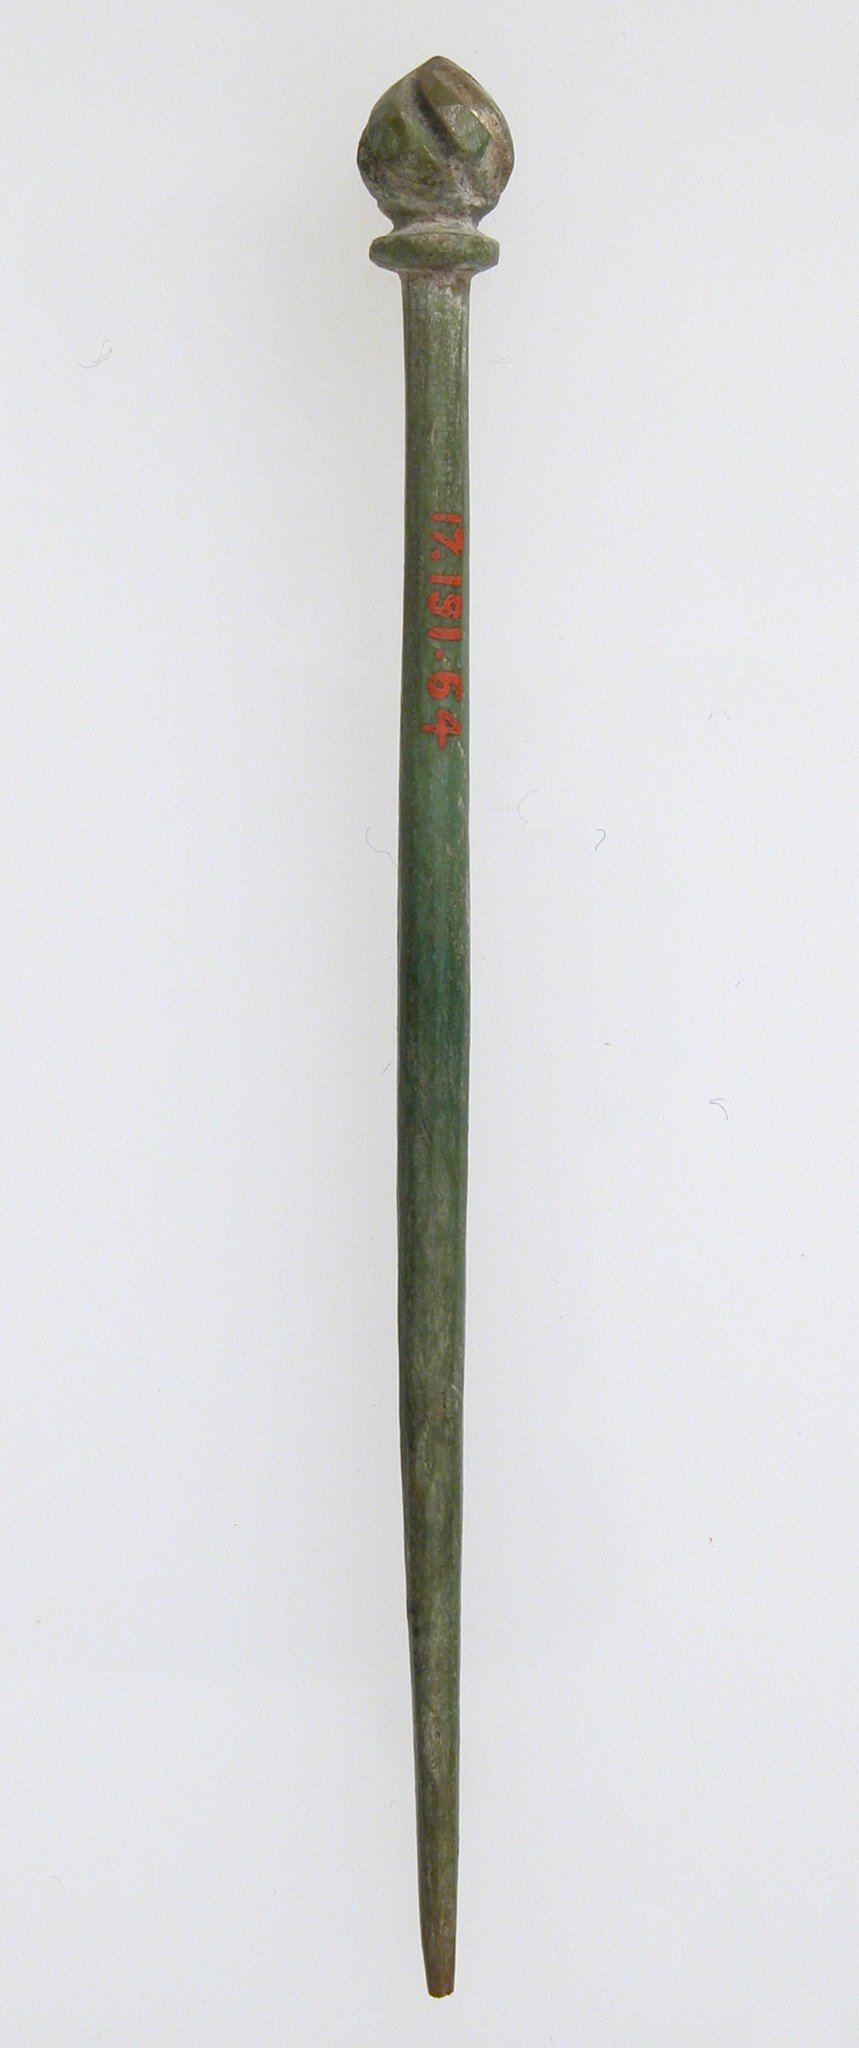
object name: hairpin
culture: roman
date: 1-400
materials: bone